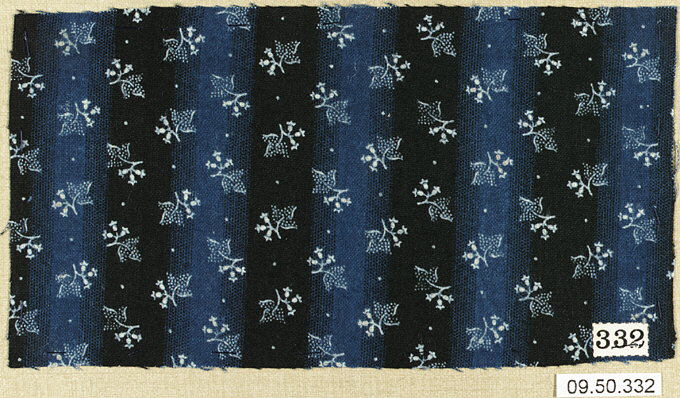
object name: piece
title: Piece (one of 116)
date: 1801-1900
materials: cotton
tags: leaves